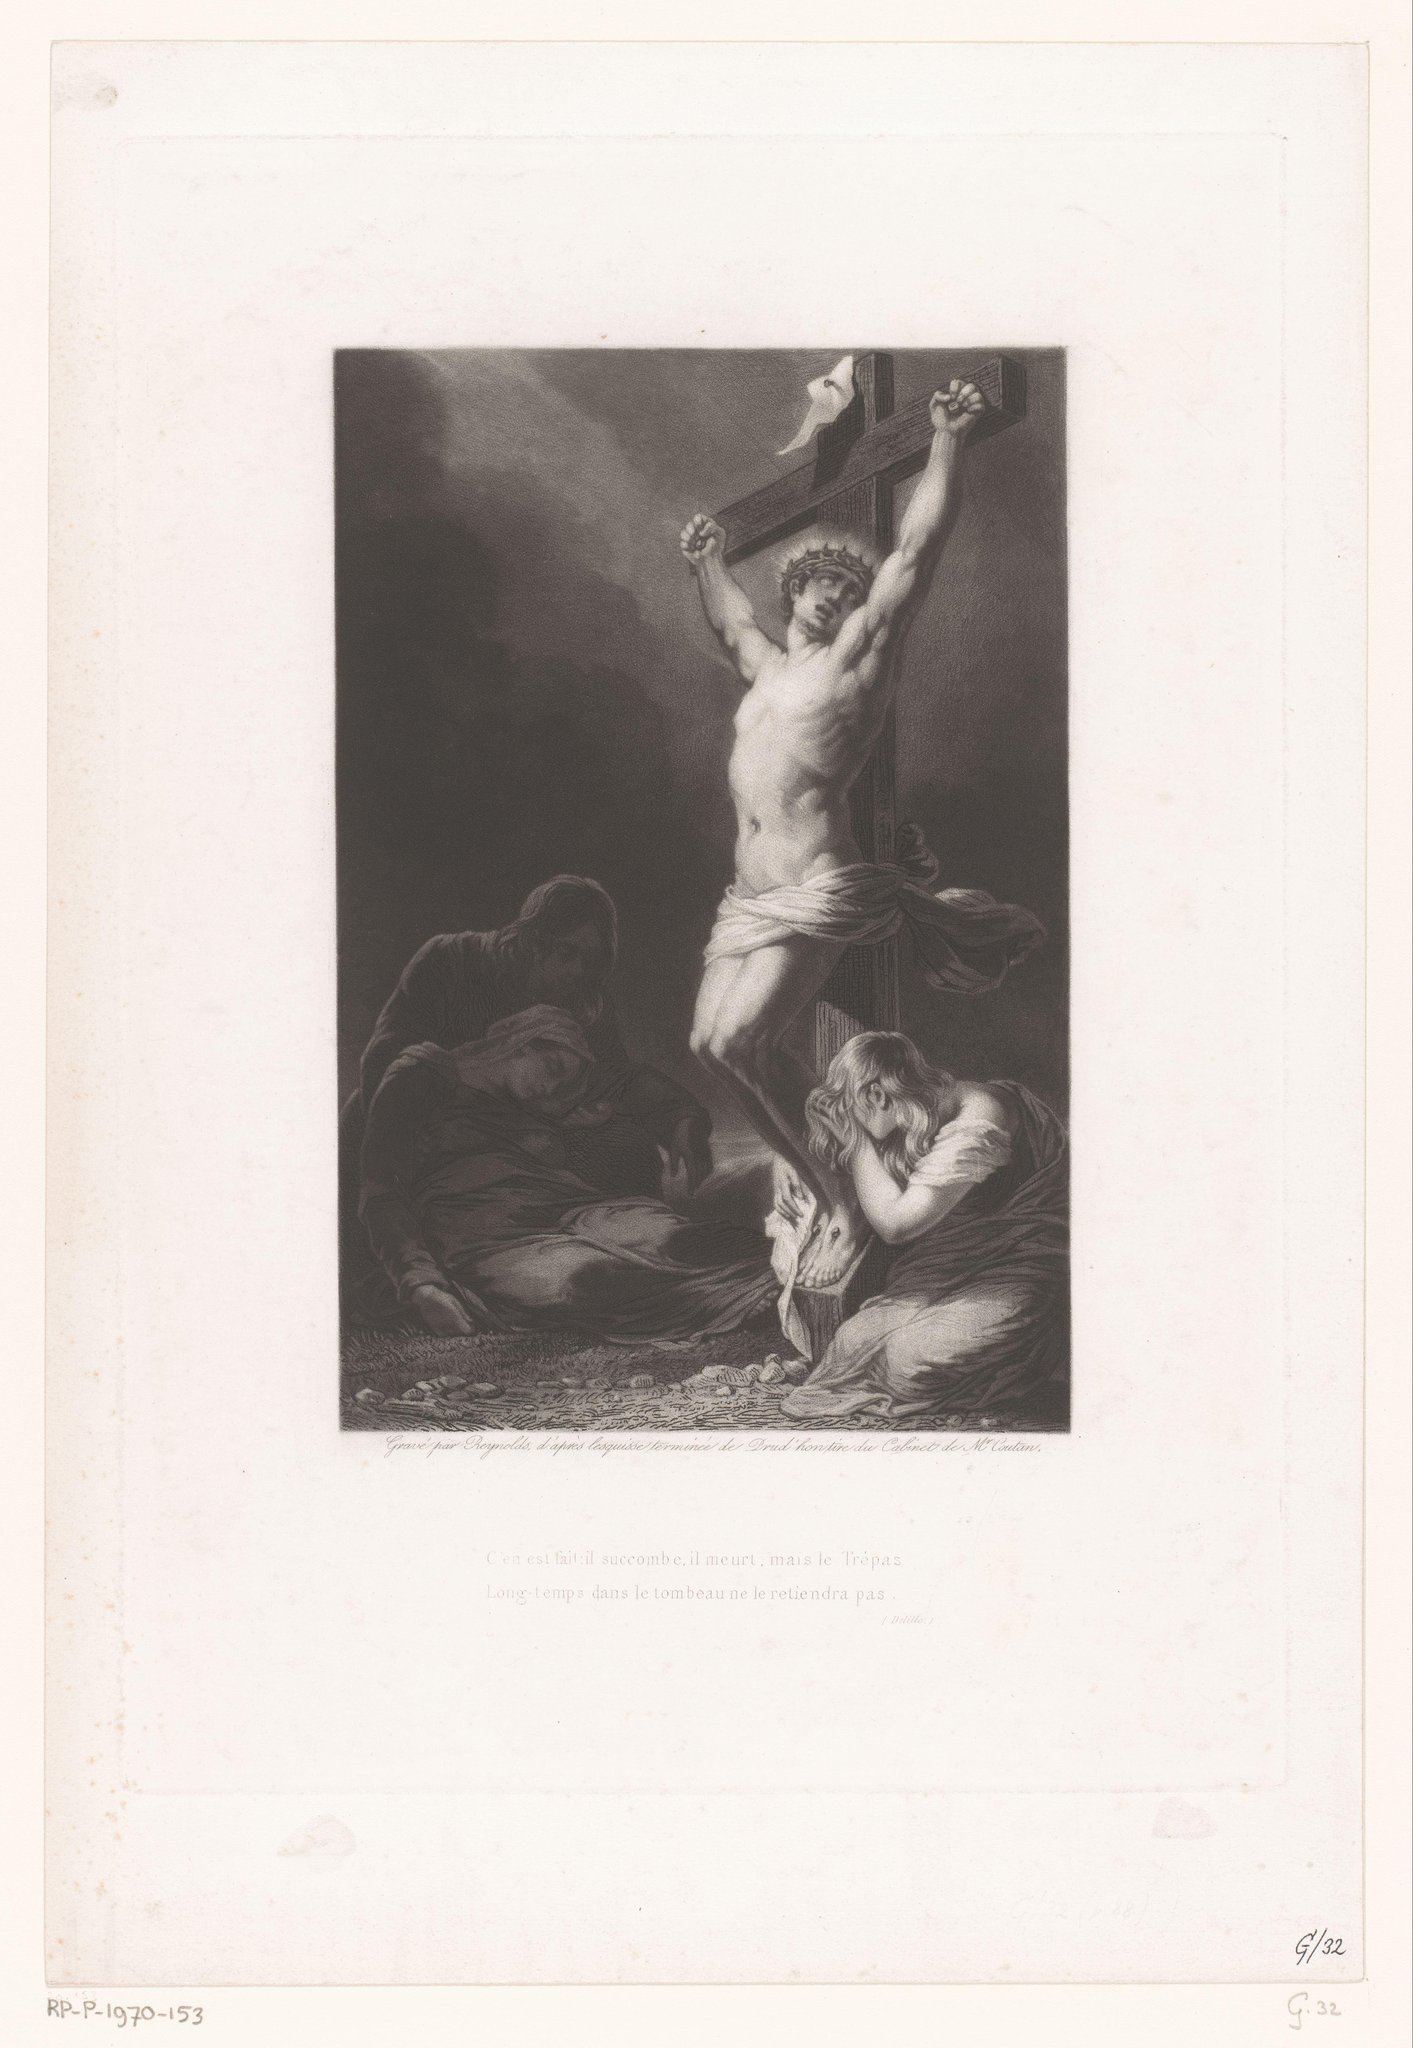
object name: print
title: Christus aan het kruis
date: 1825-1828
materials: paper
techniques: etching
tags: the crucifixion of christ: christ's death on the cross; golgotha (matthew 27:45-58; mark 15:33-45; luke 23:44-52; john 19:25-38)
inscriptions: collector's mark: Lugt 2760, collector's mark: Lugt 2228a